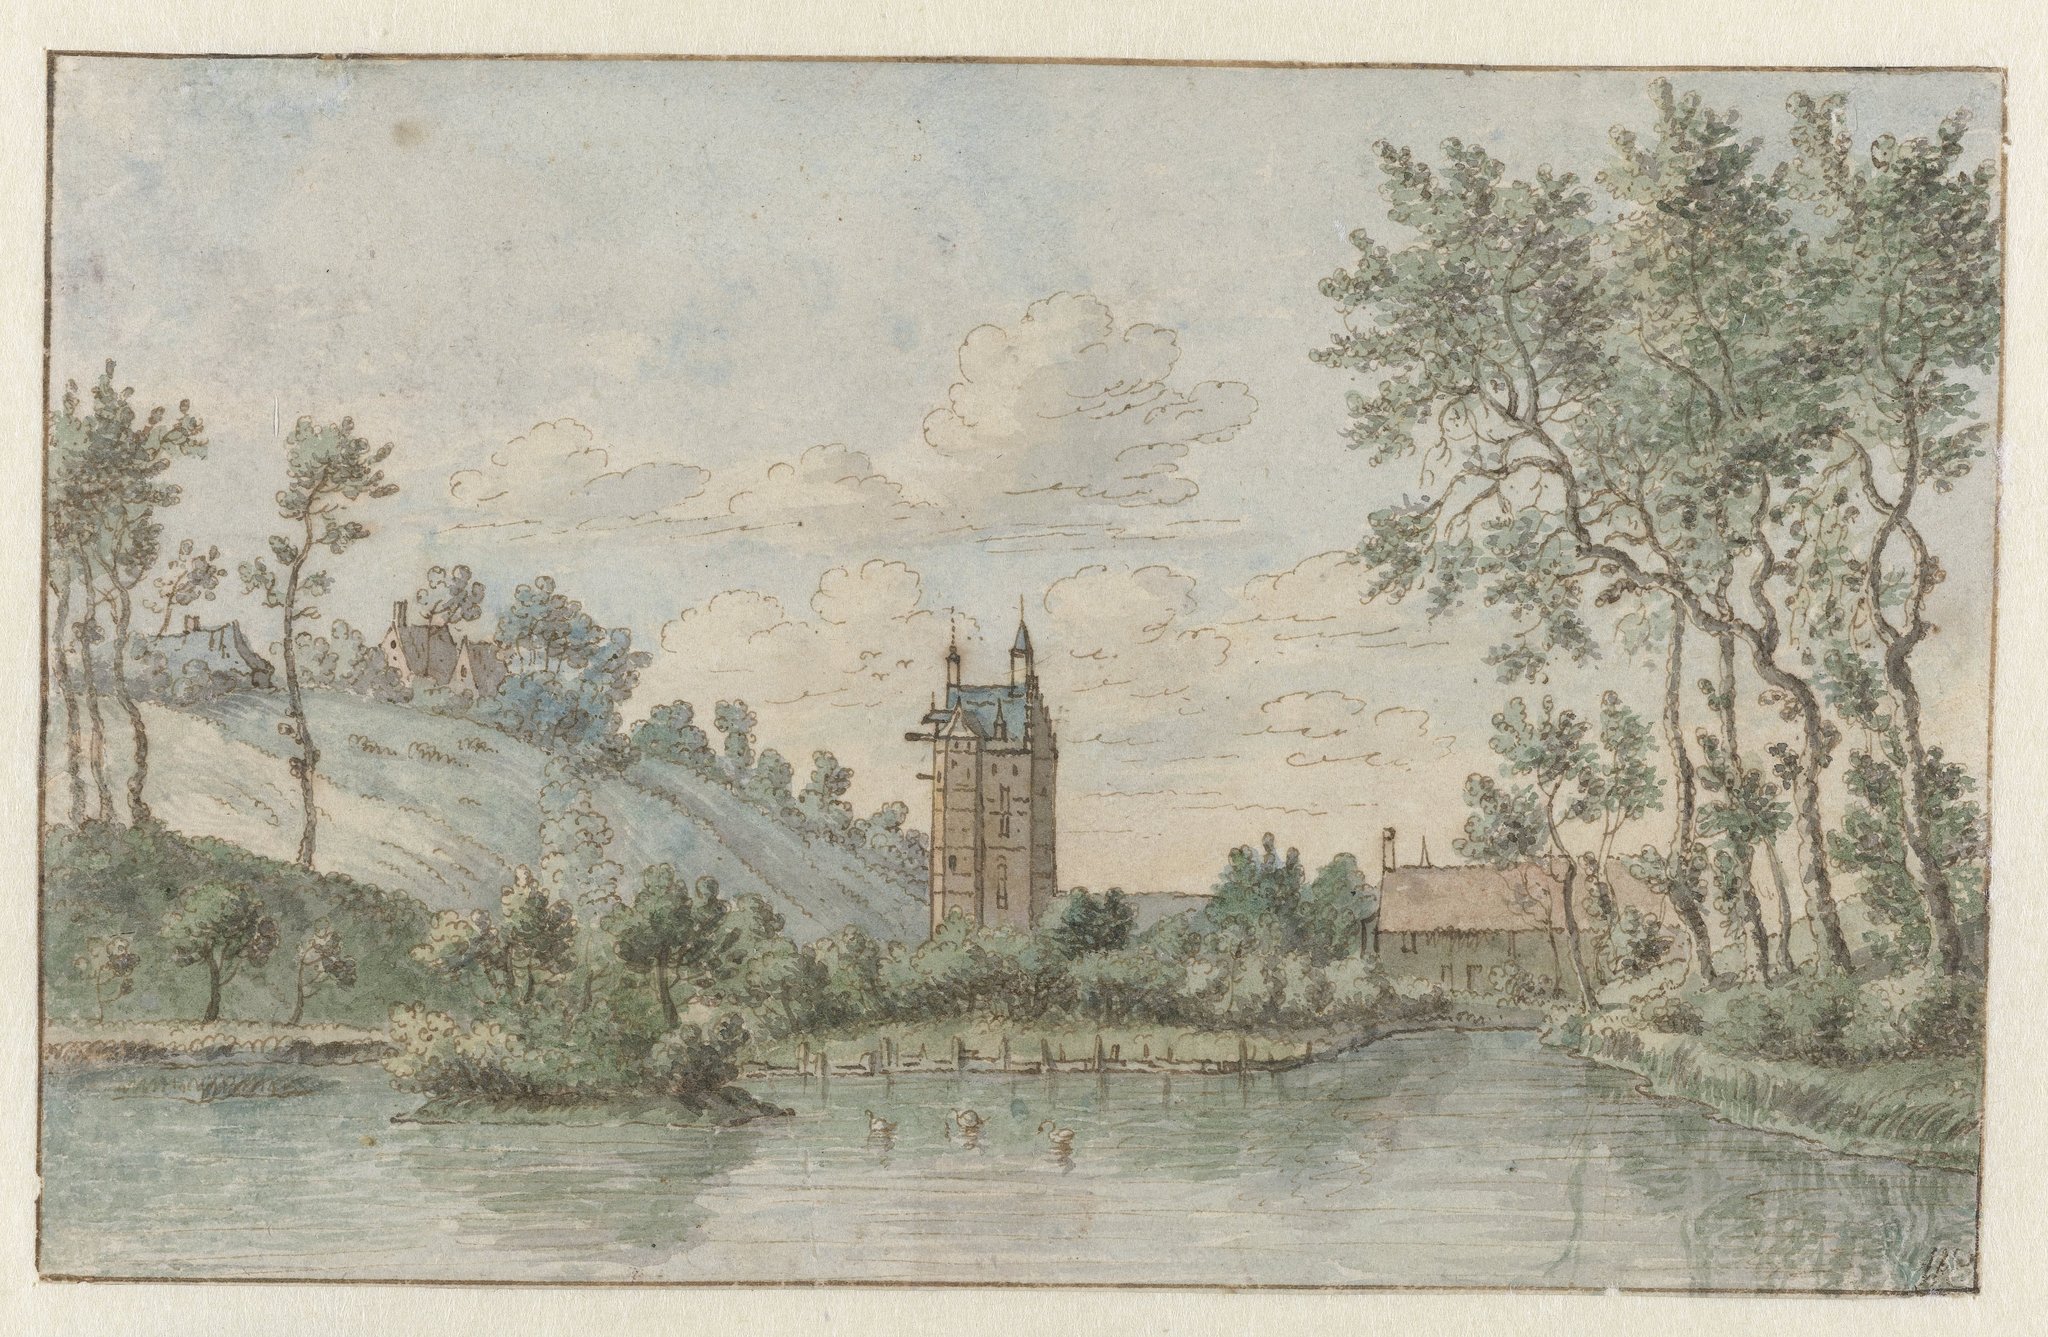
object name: drawing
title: Landscape with Huis Kluys, near Brussels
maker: josua de grave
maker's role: draughtsman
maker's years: 1645-1712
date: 1674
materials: ink, paper, watercolor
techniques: brush, pen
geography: brussels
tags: rural housing, e.g. country-house, villa, cottage, farm or solitary house in landscape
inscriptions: date: ‘1674’